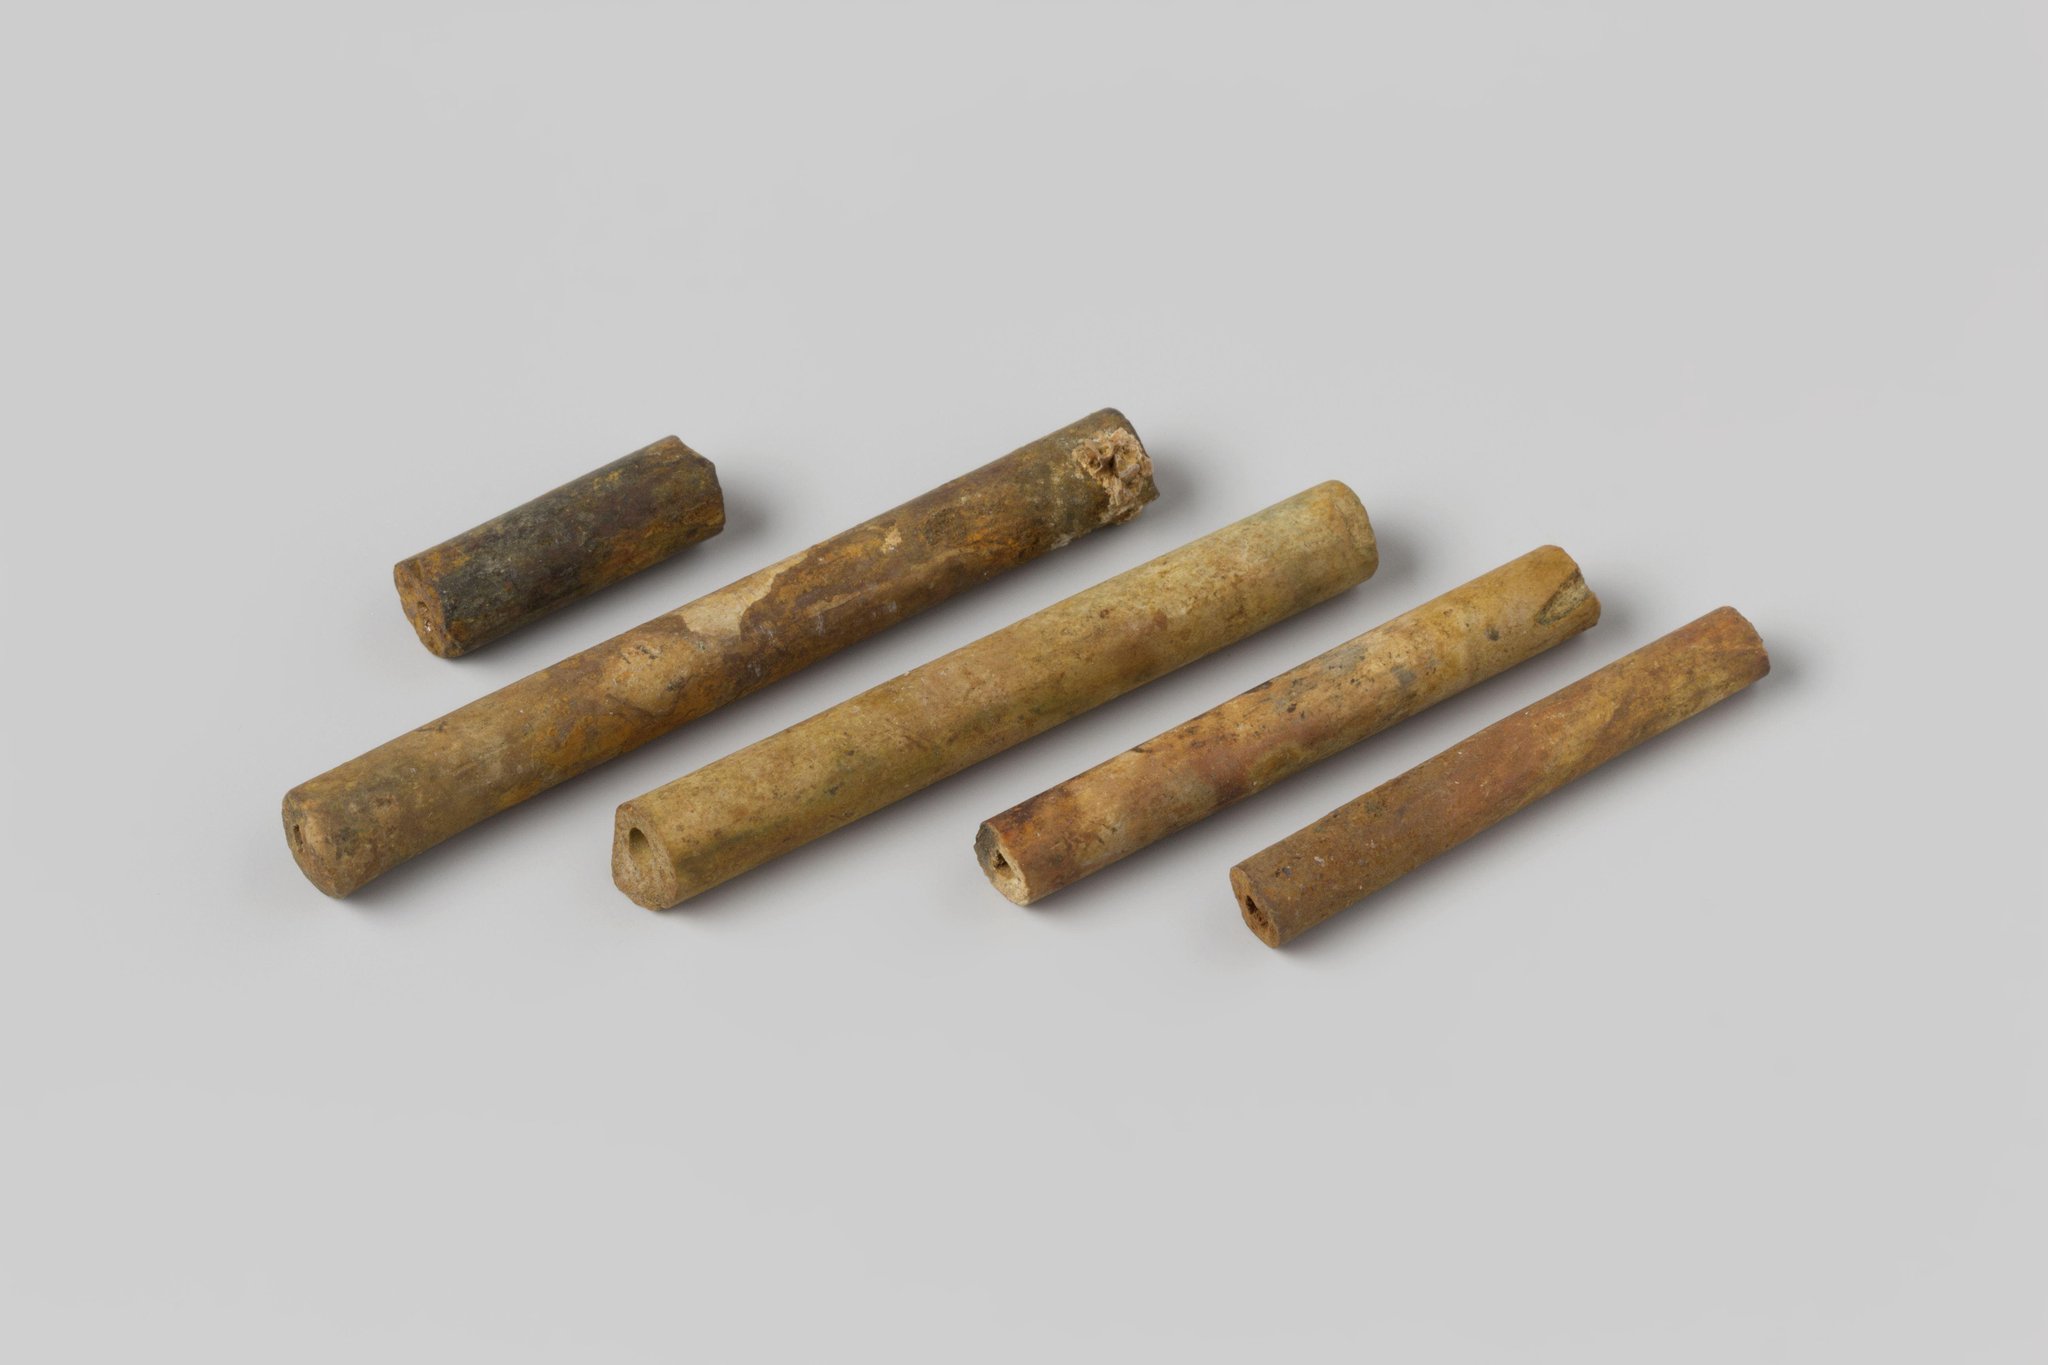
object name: pipe stem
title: Fragmenten pijpenstelen uit het wrak van de Oost-Indiëvaarder Hollandia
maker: Anonymous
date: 1700-1743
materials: clay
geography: netherlands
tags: verenigde oostindische compagnie, hollandia (schip), annet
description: Pipe, stem; fragments, decoration id. NG 1980-27H501 inscription [?G?VSCHU?T?, GOUDA?].